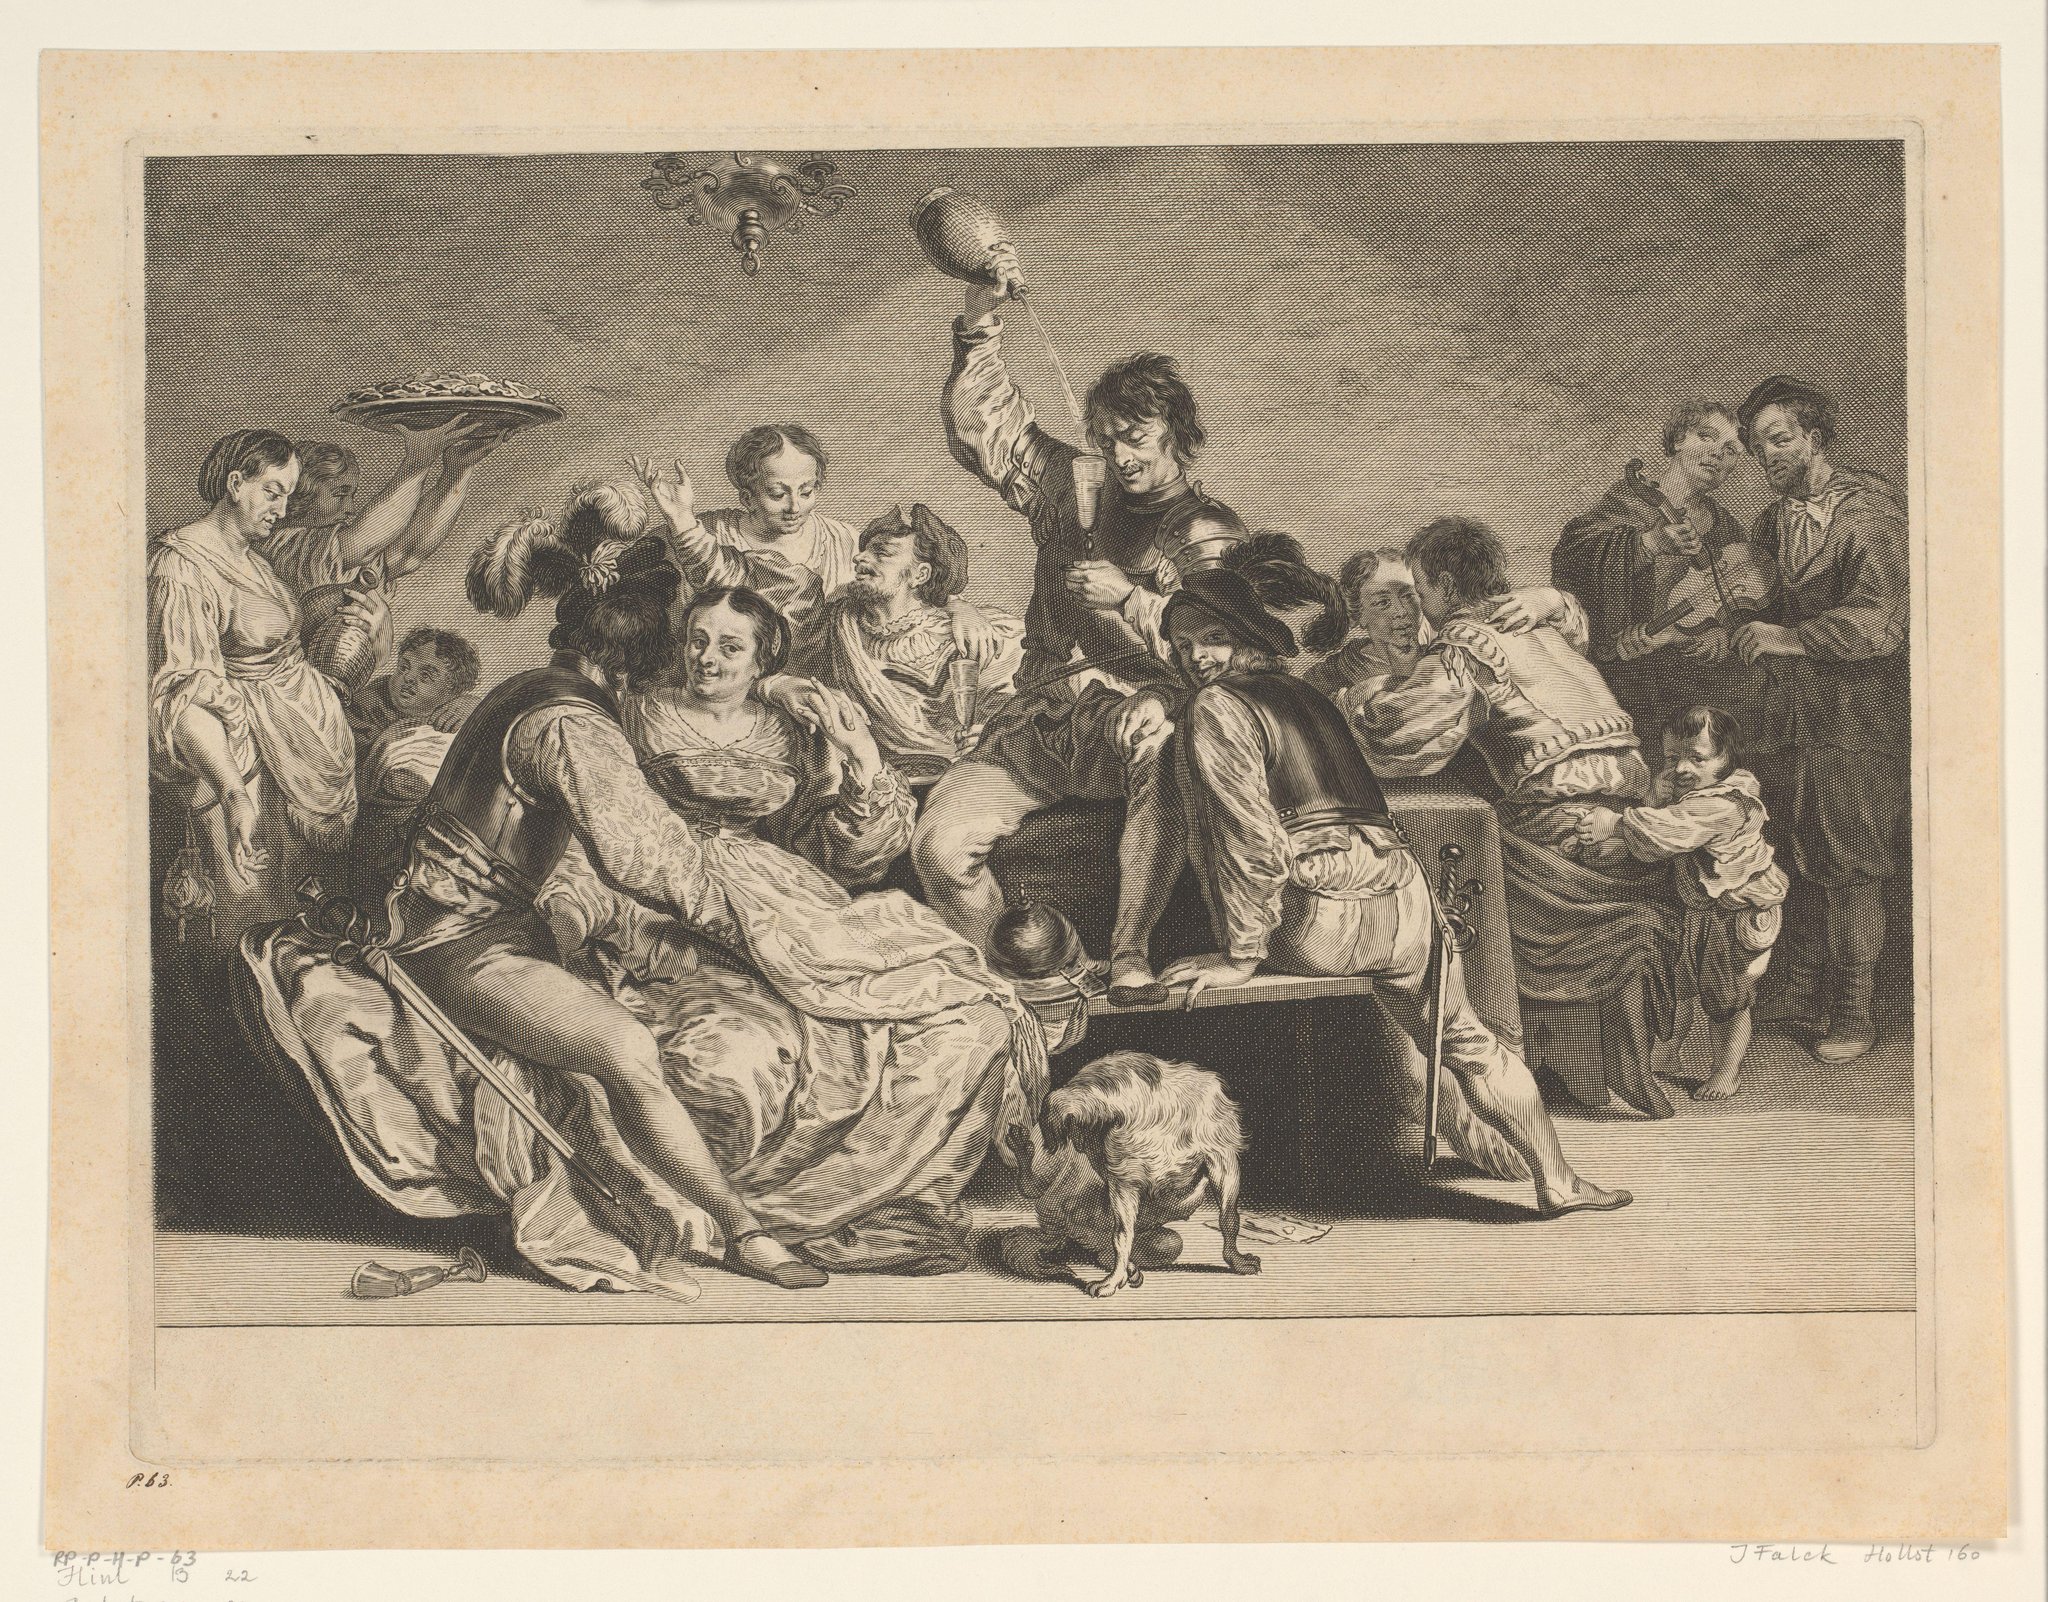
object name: print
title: Caelaturae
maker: jeremias falck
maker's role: print maker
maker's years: 1609-1677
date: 1646-1658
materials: paper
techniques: engraving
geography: amsterdam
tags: brothel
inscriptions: collector's mark: Lugt 11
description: Deze prent maakte ten minste tot 1979 deel uit van een prentalbum met de titel: 't Cabinet der Italiaense schilderije antique statue en borstbeelde van de heer Renst 145 stucks. Simon Schijnvoet heeft in 1709 aan dit album het Schijnvoet-nummer 22, liber nummer 20 toegekend. Prent uit serie Caelaturae met vierendertig reprodukties naar Italiaanse en Nederlandse schilders, vervaardigd door de allerbeste graveurs in opdracht van de verzamelaar Gerard Reynst.